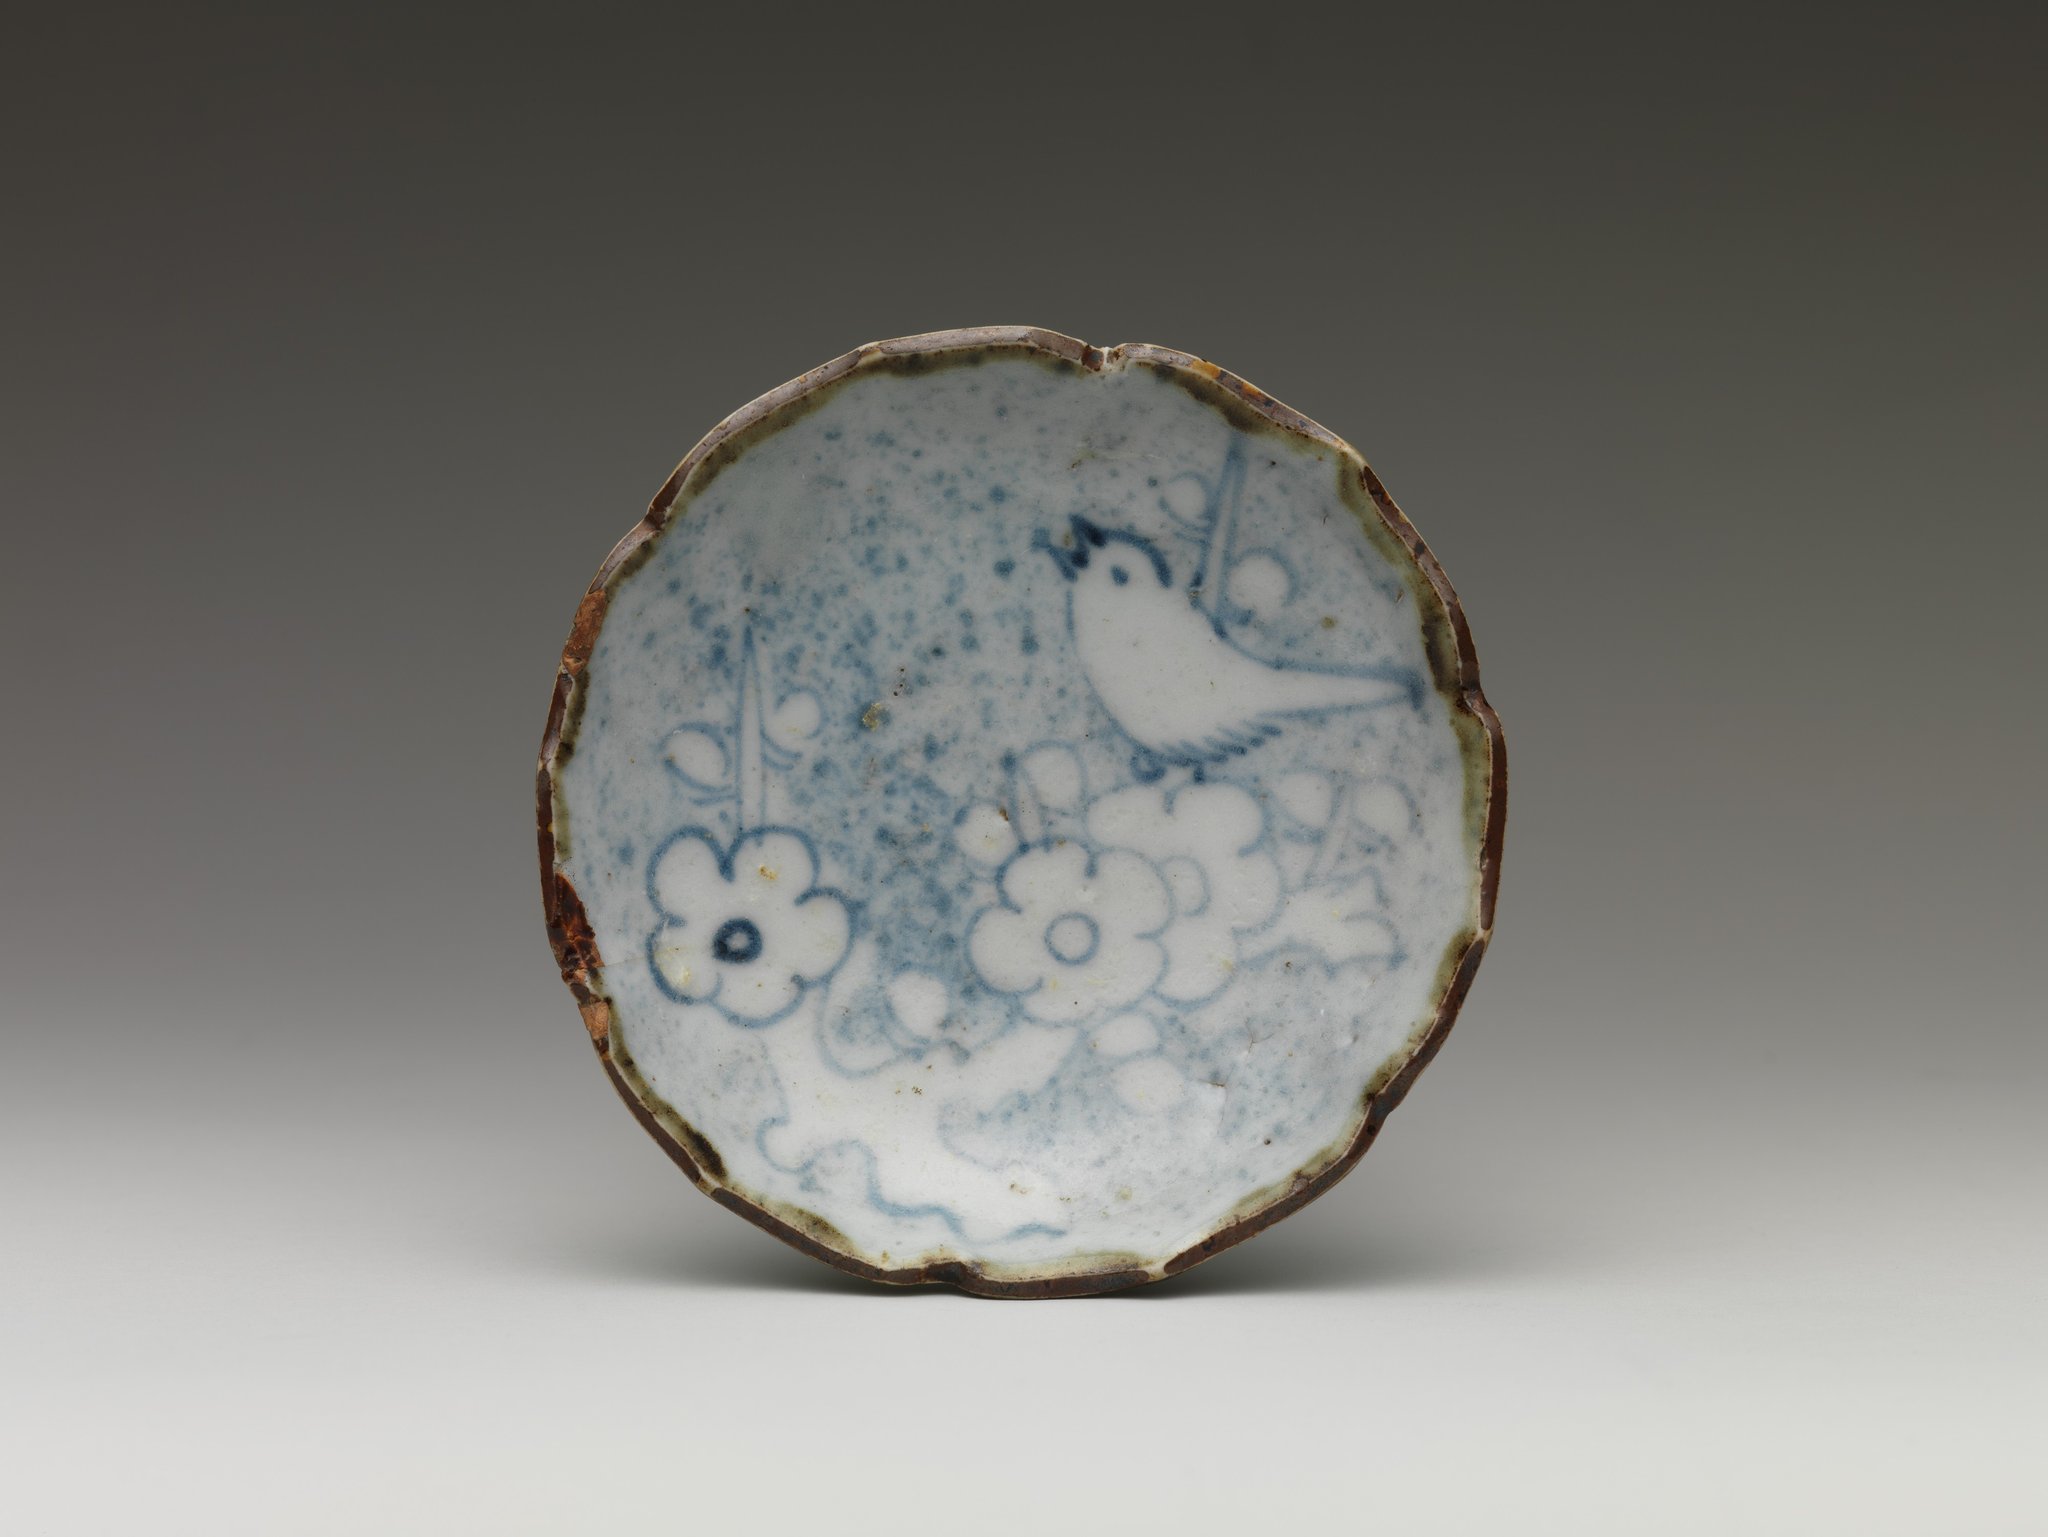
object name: dish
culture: japanese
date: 1640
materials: porcelain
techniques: underglaze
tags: birds